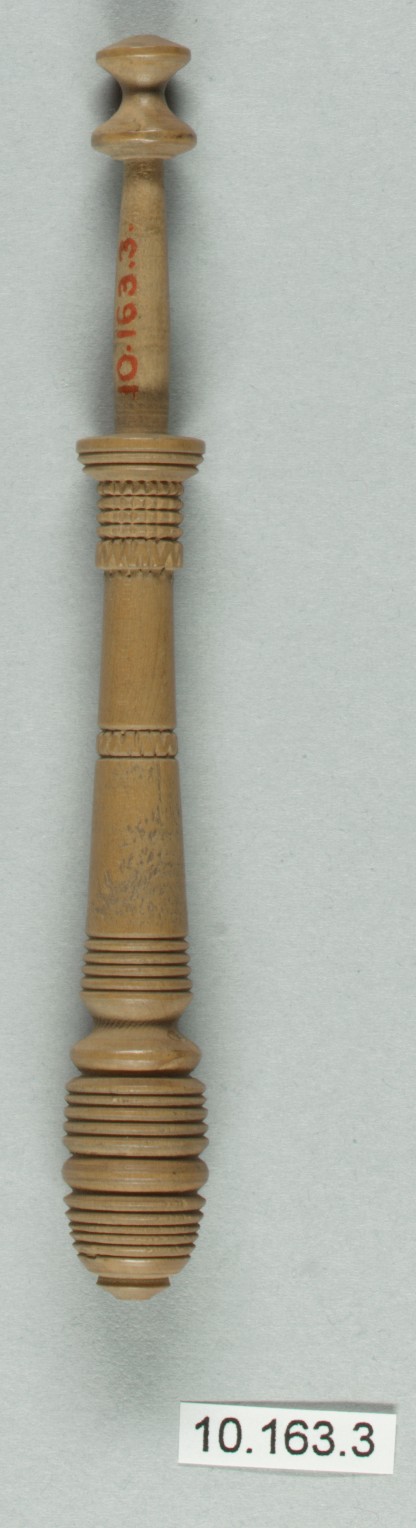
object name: bobbin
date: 1801-1900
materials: wood